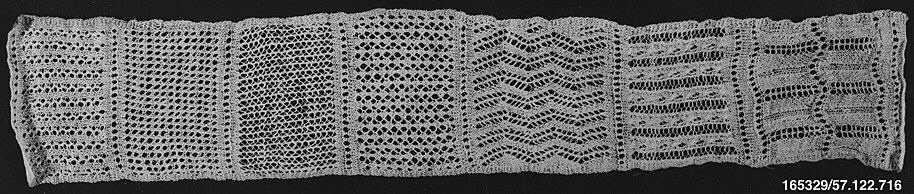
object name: sampler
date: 1801-1900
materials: lace, wool